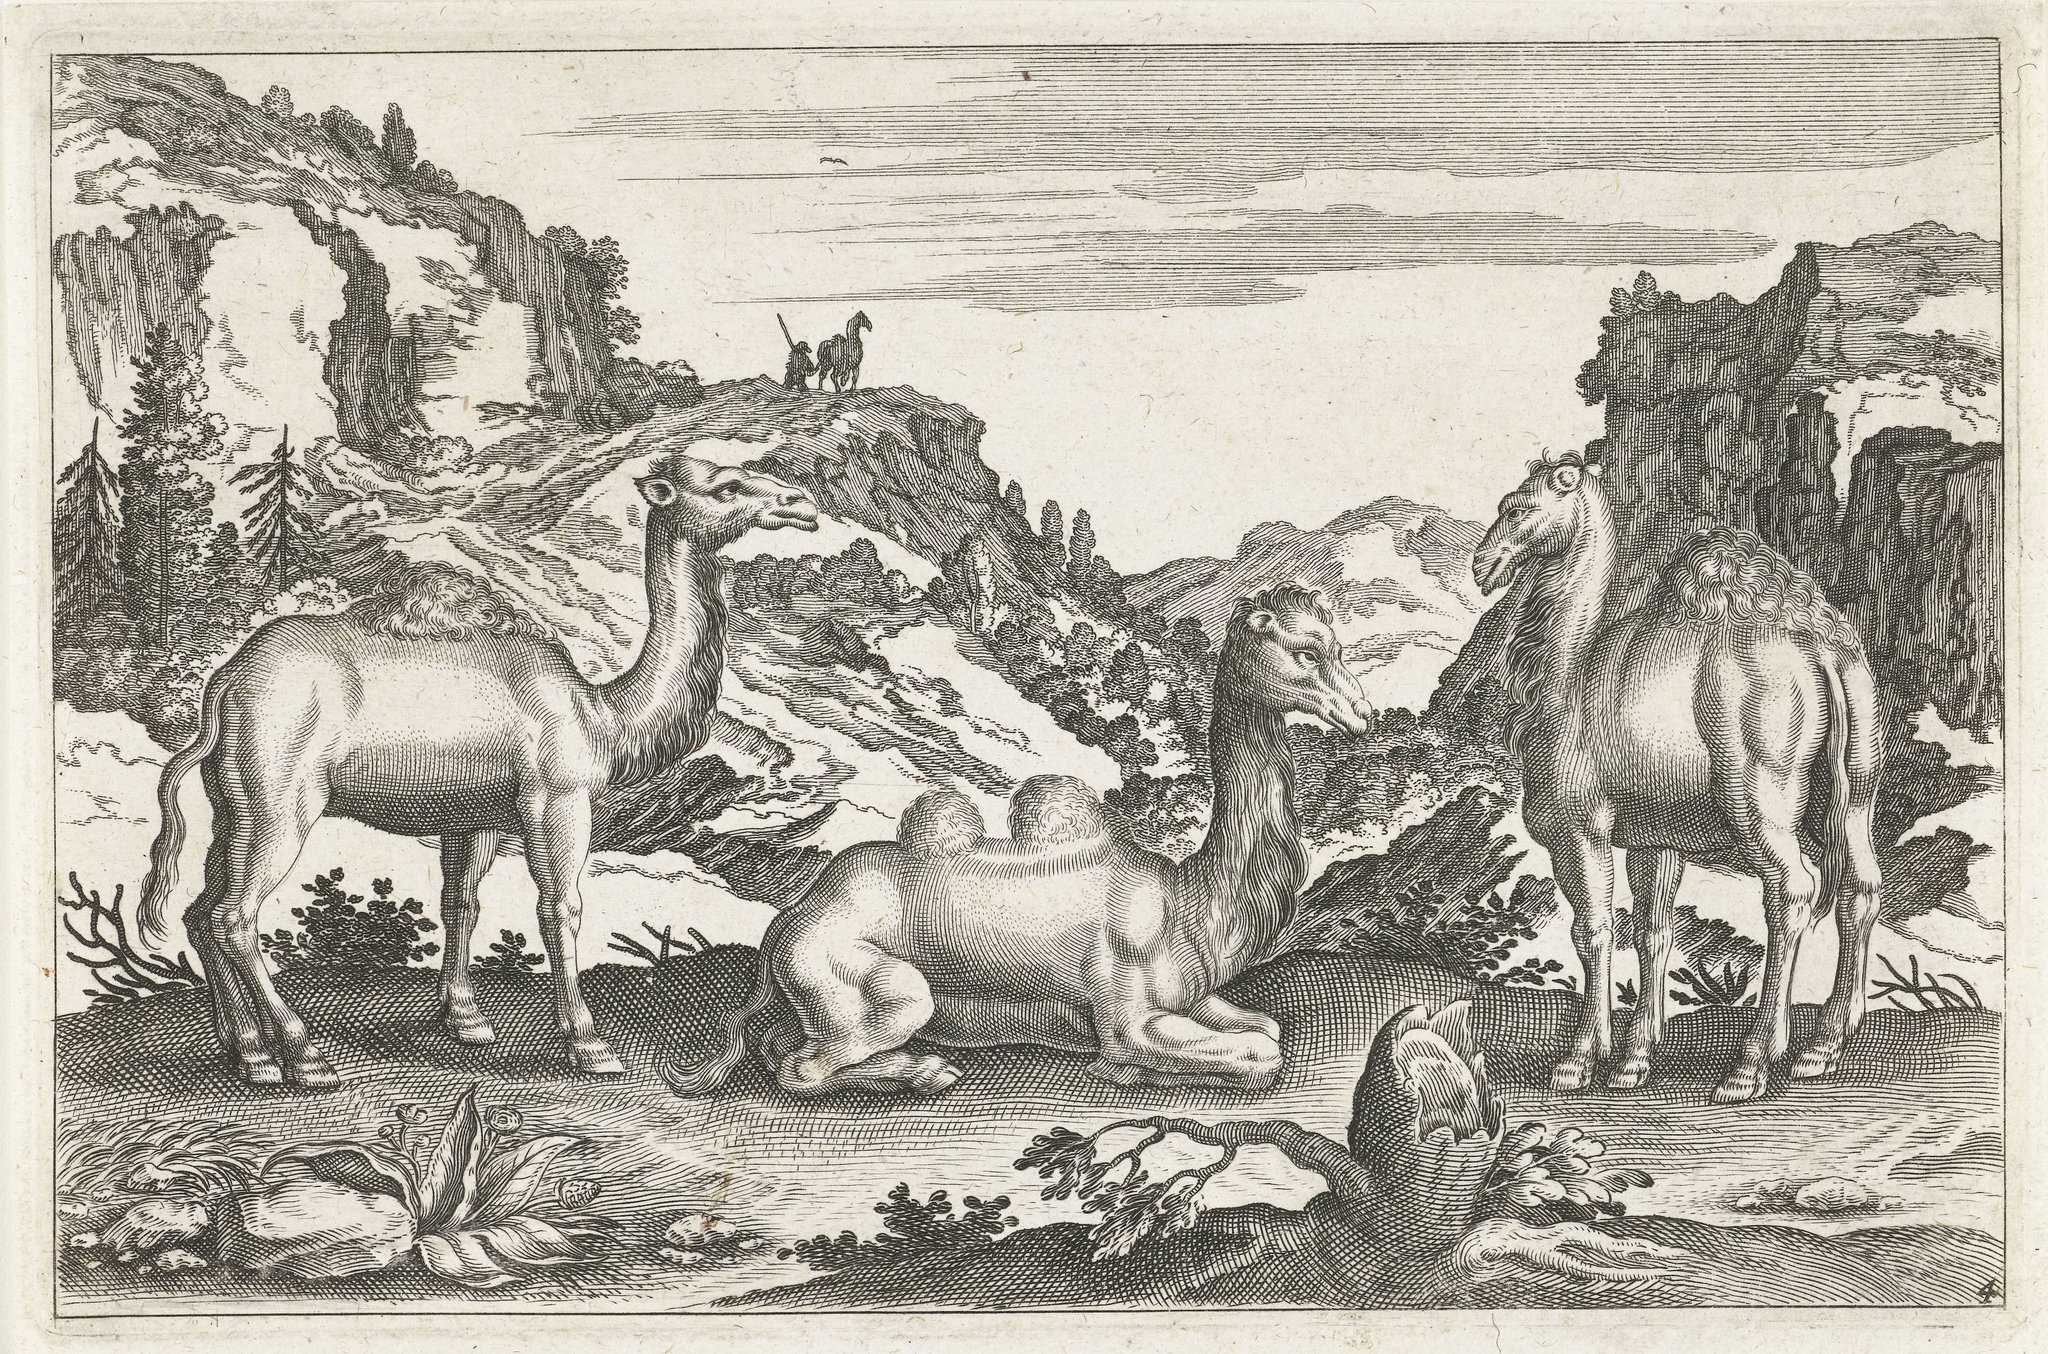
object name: print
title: Animalivm Qvaddrvpedvm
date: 1628-1679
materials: paper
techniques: engraving, etching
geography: amsterdam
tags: hoofed animals: camel, hoofed animals: dromedary, river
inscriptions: collector's mark: Lugt 2228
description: Op de voorgrond twee dromedarissen en een kameel. Op de achtergrond een berglandschap. De prent maakt deel uit van een serie met dieren als onderwerp.